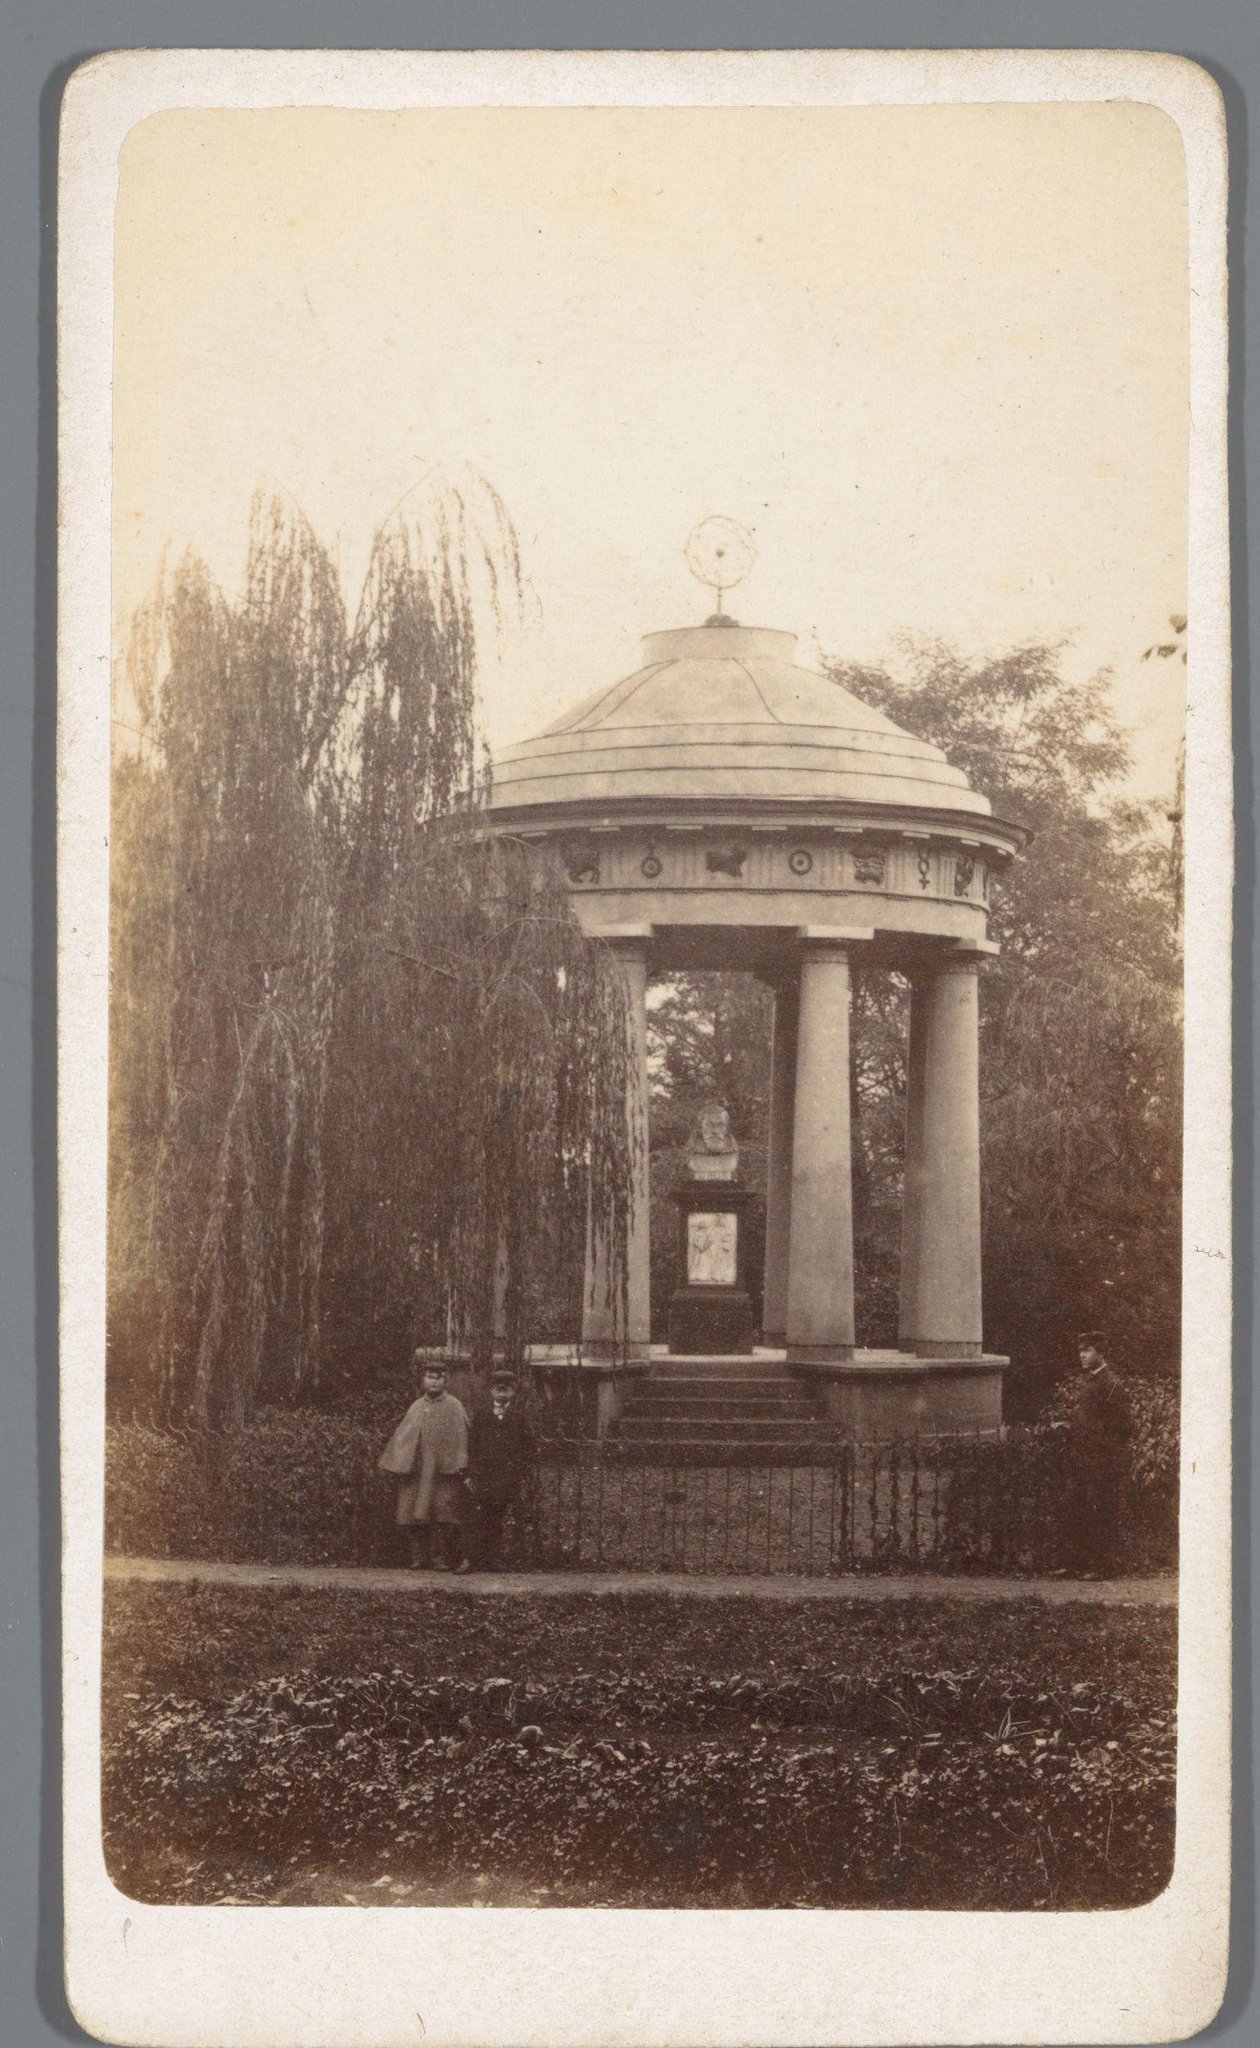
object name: carte de visite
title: Monument voor Keppler, Regensburg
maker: johann laifle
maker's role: fotograaf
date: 1855-1885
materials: cardboard, paper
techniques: albumen print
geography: regensburg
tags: monument, statue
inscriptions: inscription: ‘JOH. LAIFLE/ PHOTOGRAPH/ in/ REGENSBURG.’